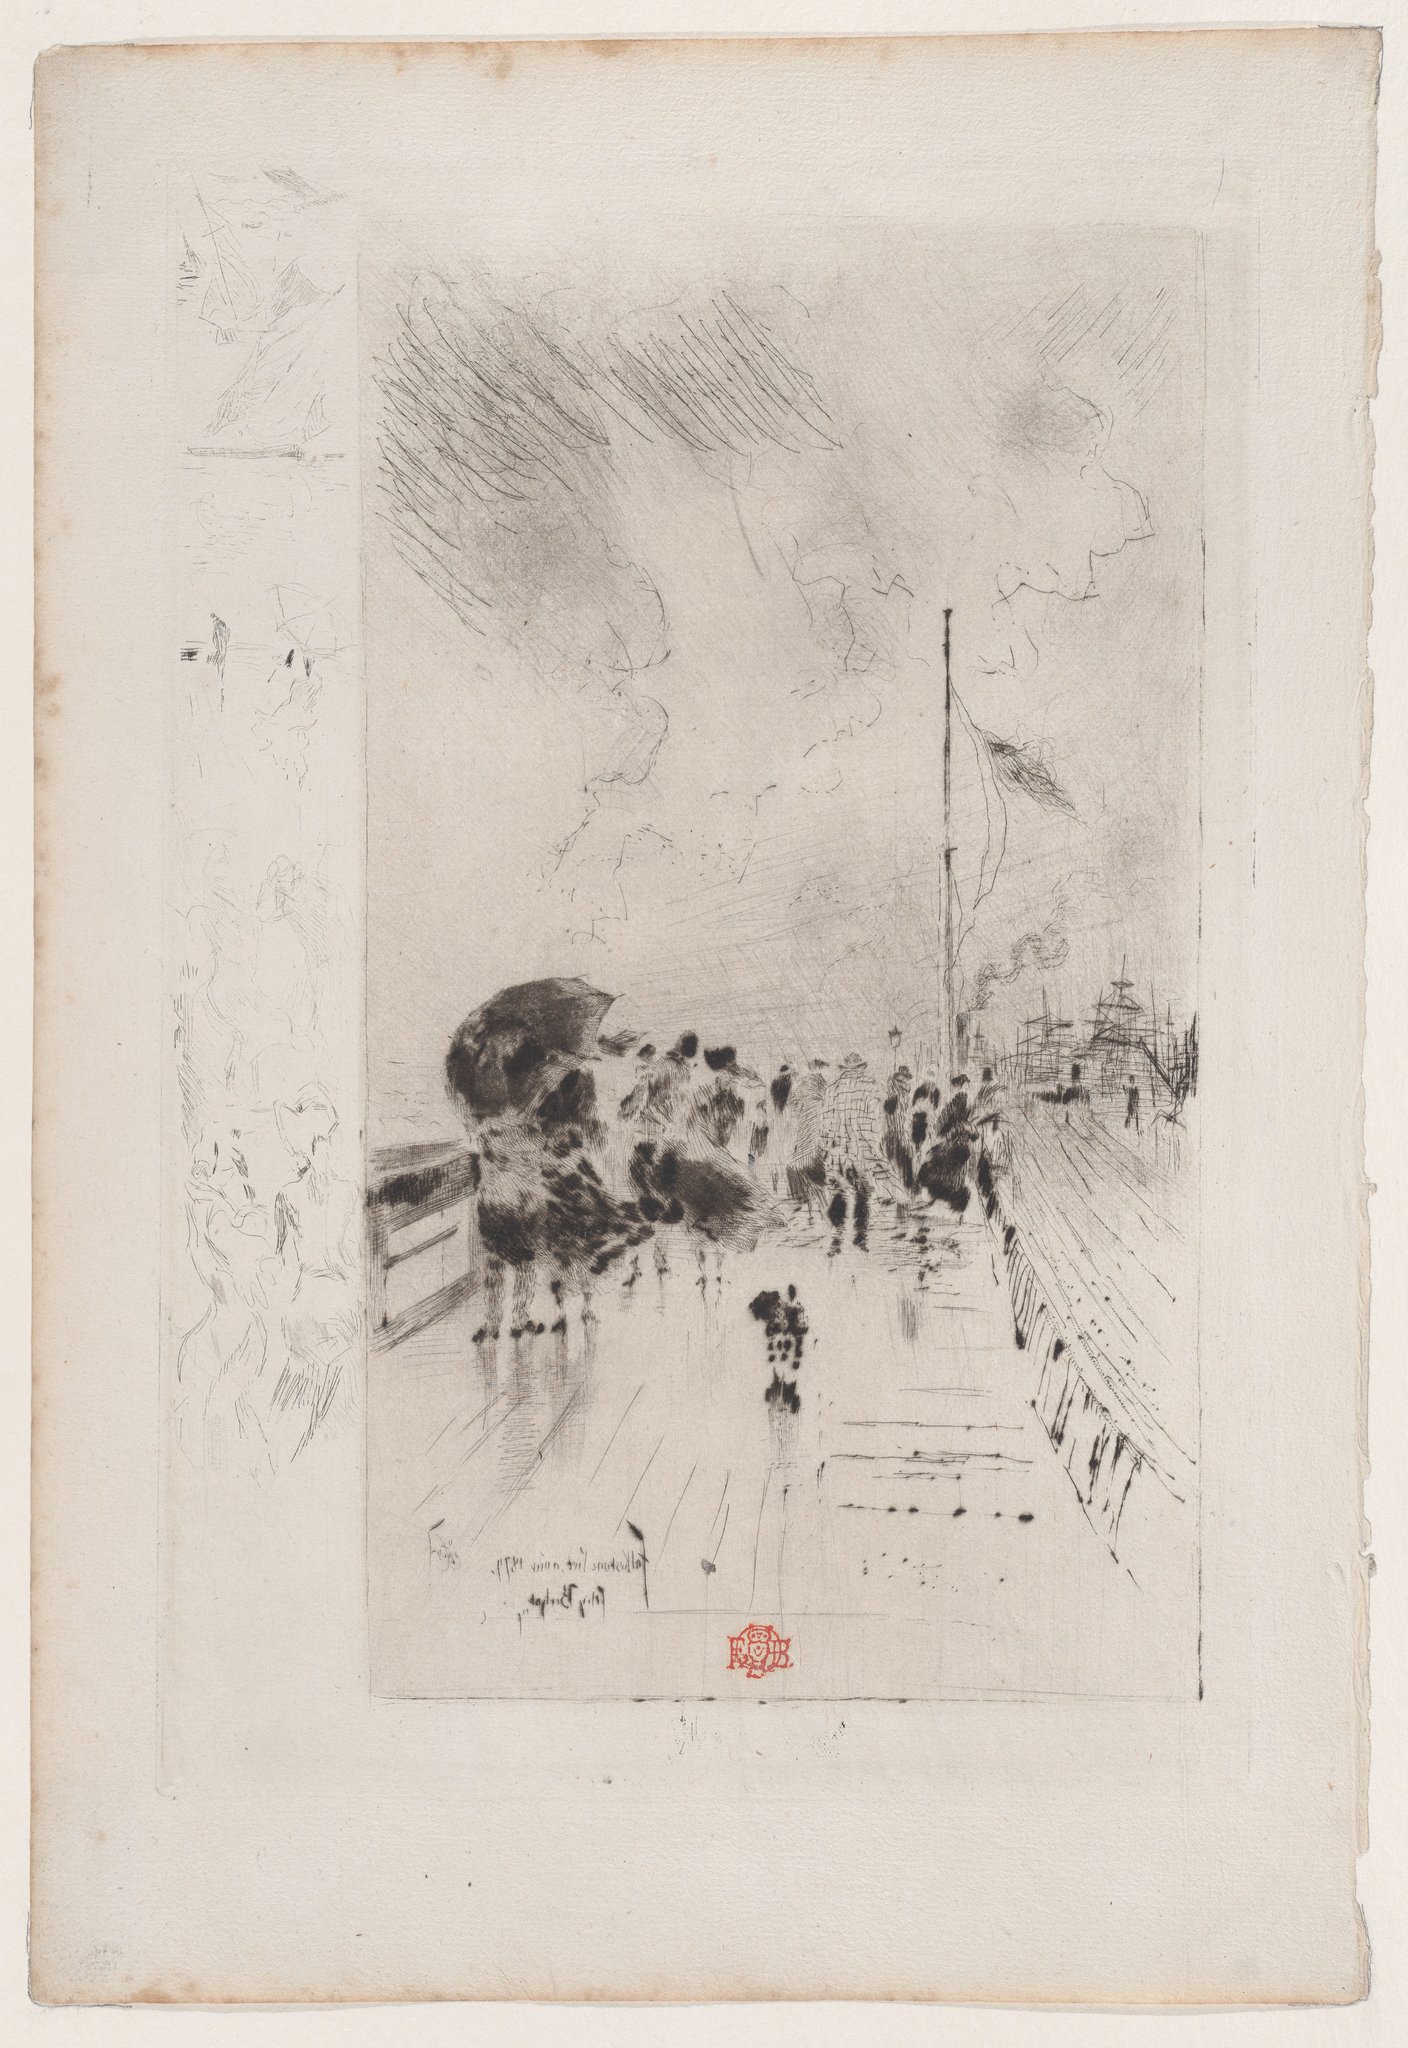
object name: print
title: A Jetty in England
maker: félix-hilaire buhot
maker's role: artist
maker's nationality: french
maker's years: 1847-1898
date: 1879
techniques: drypoint, roulette